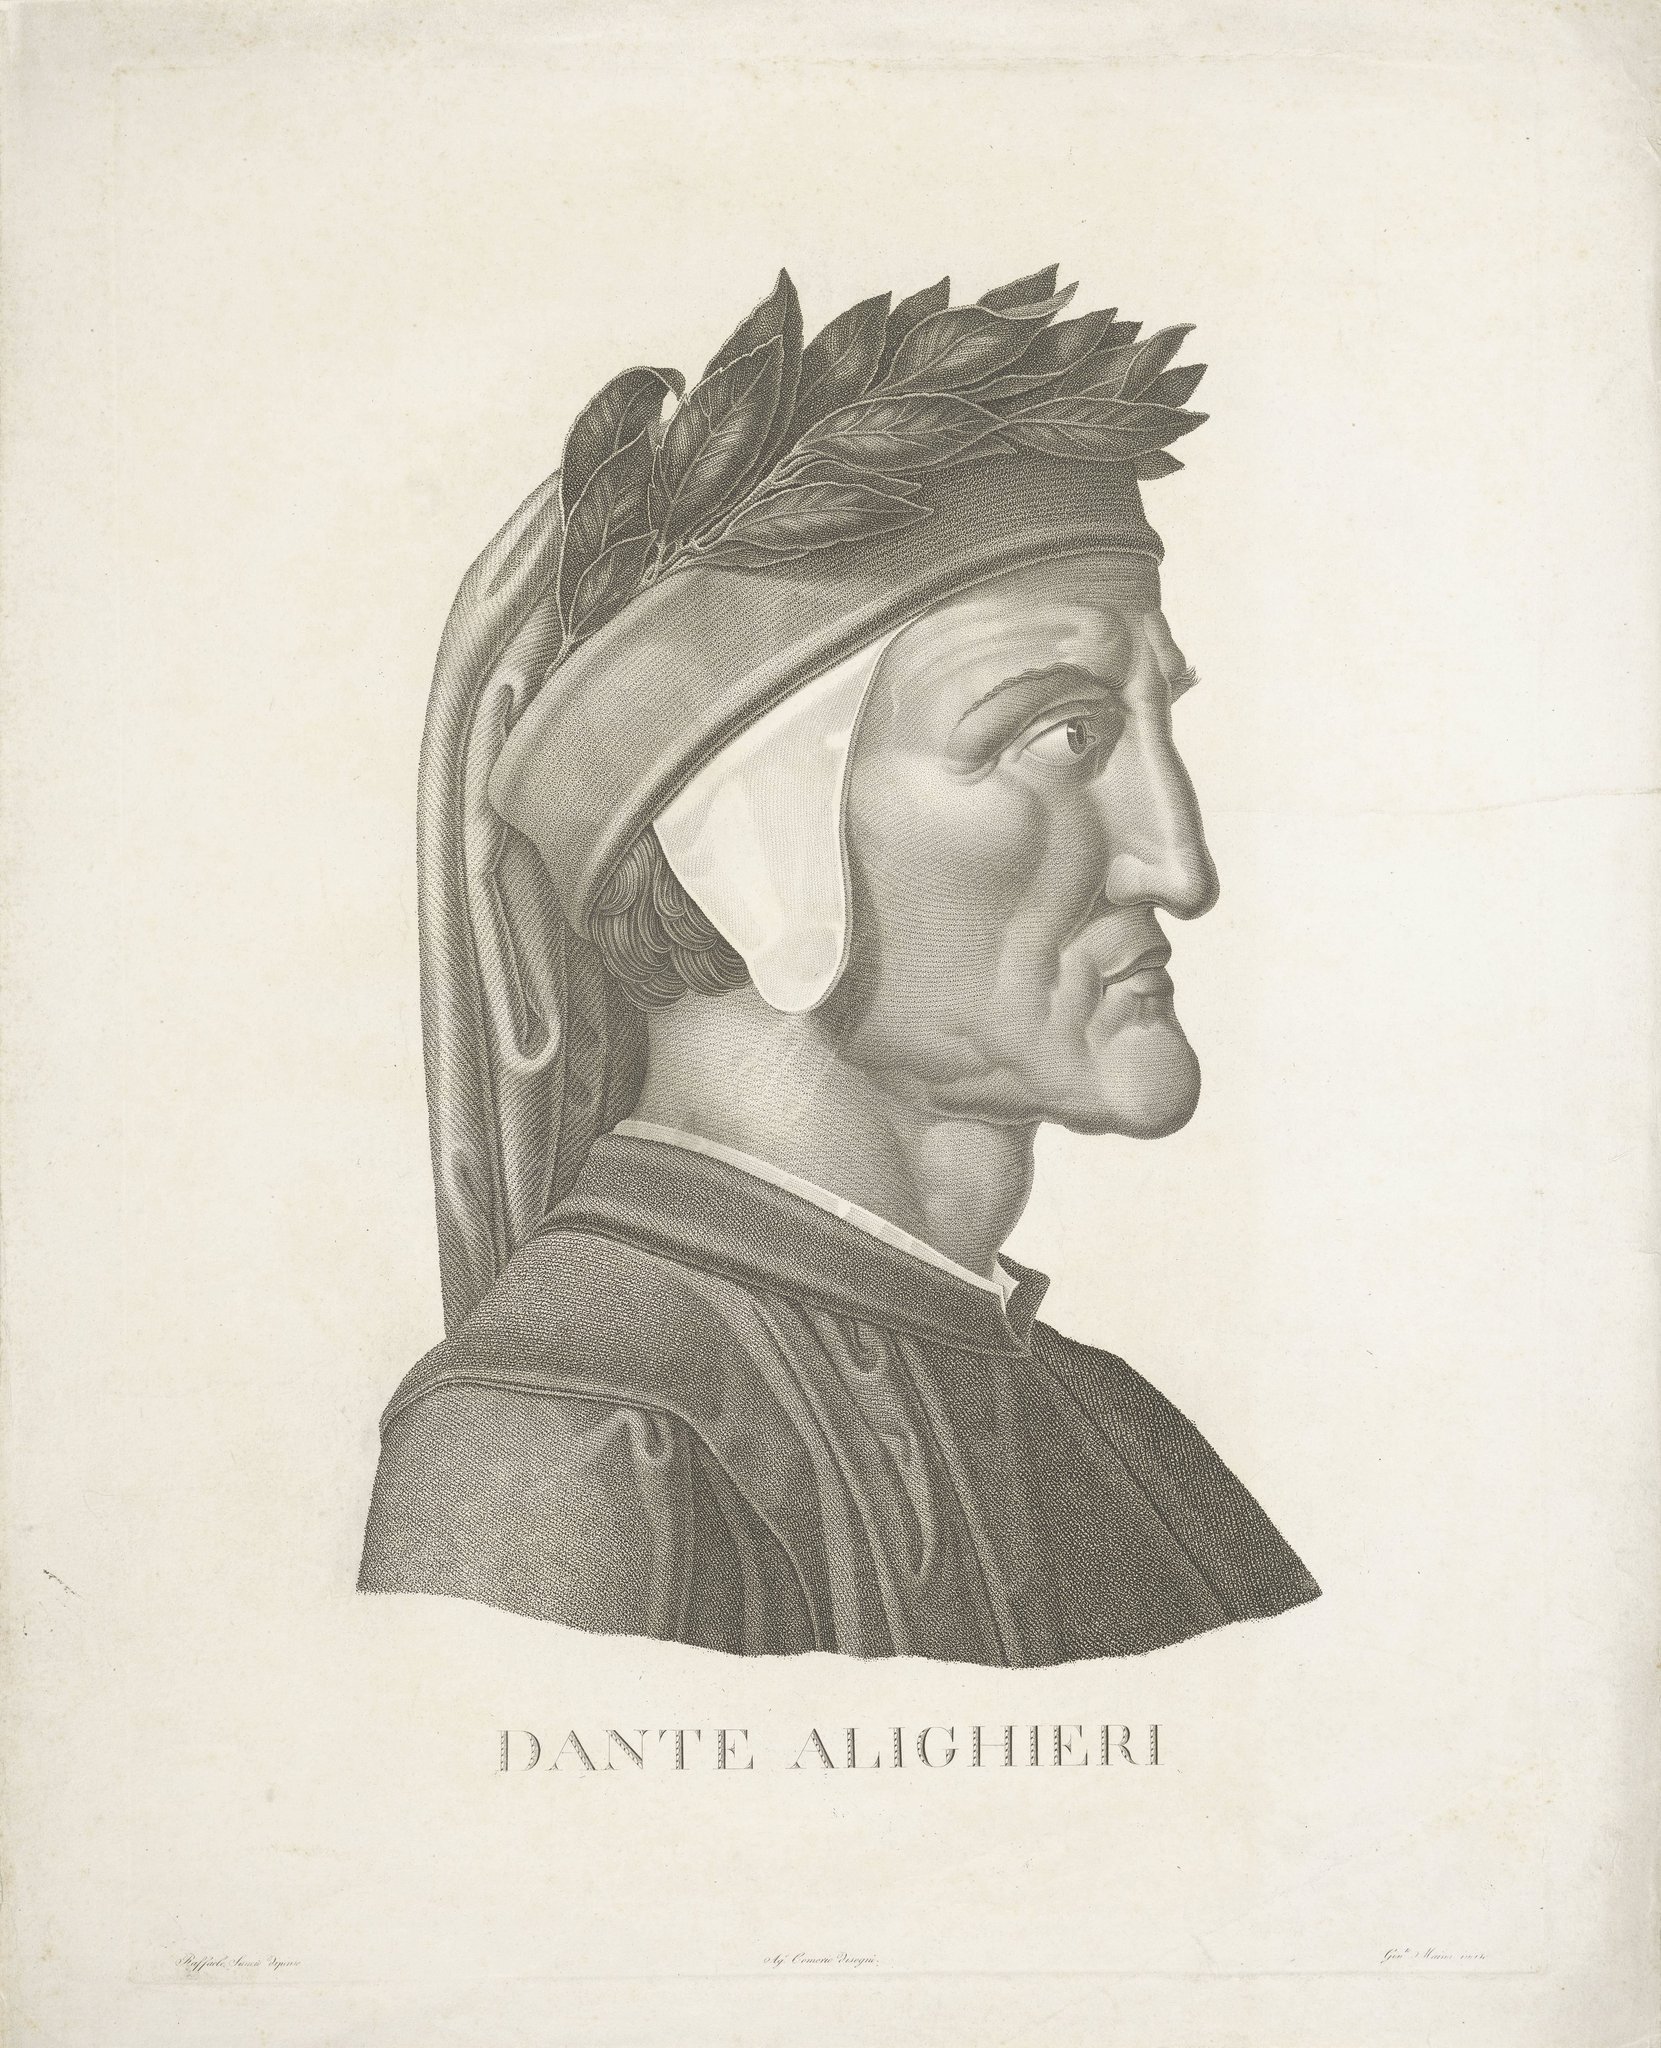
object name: print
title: Portret van Dante Alighieri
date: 1800-1899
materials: paper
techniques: engraving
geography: italy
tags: dante alighieri, historical persons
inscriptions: collector's mark: Lugt 2228